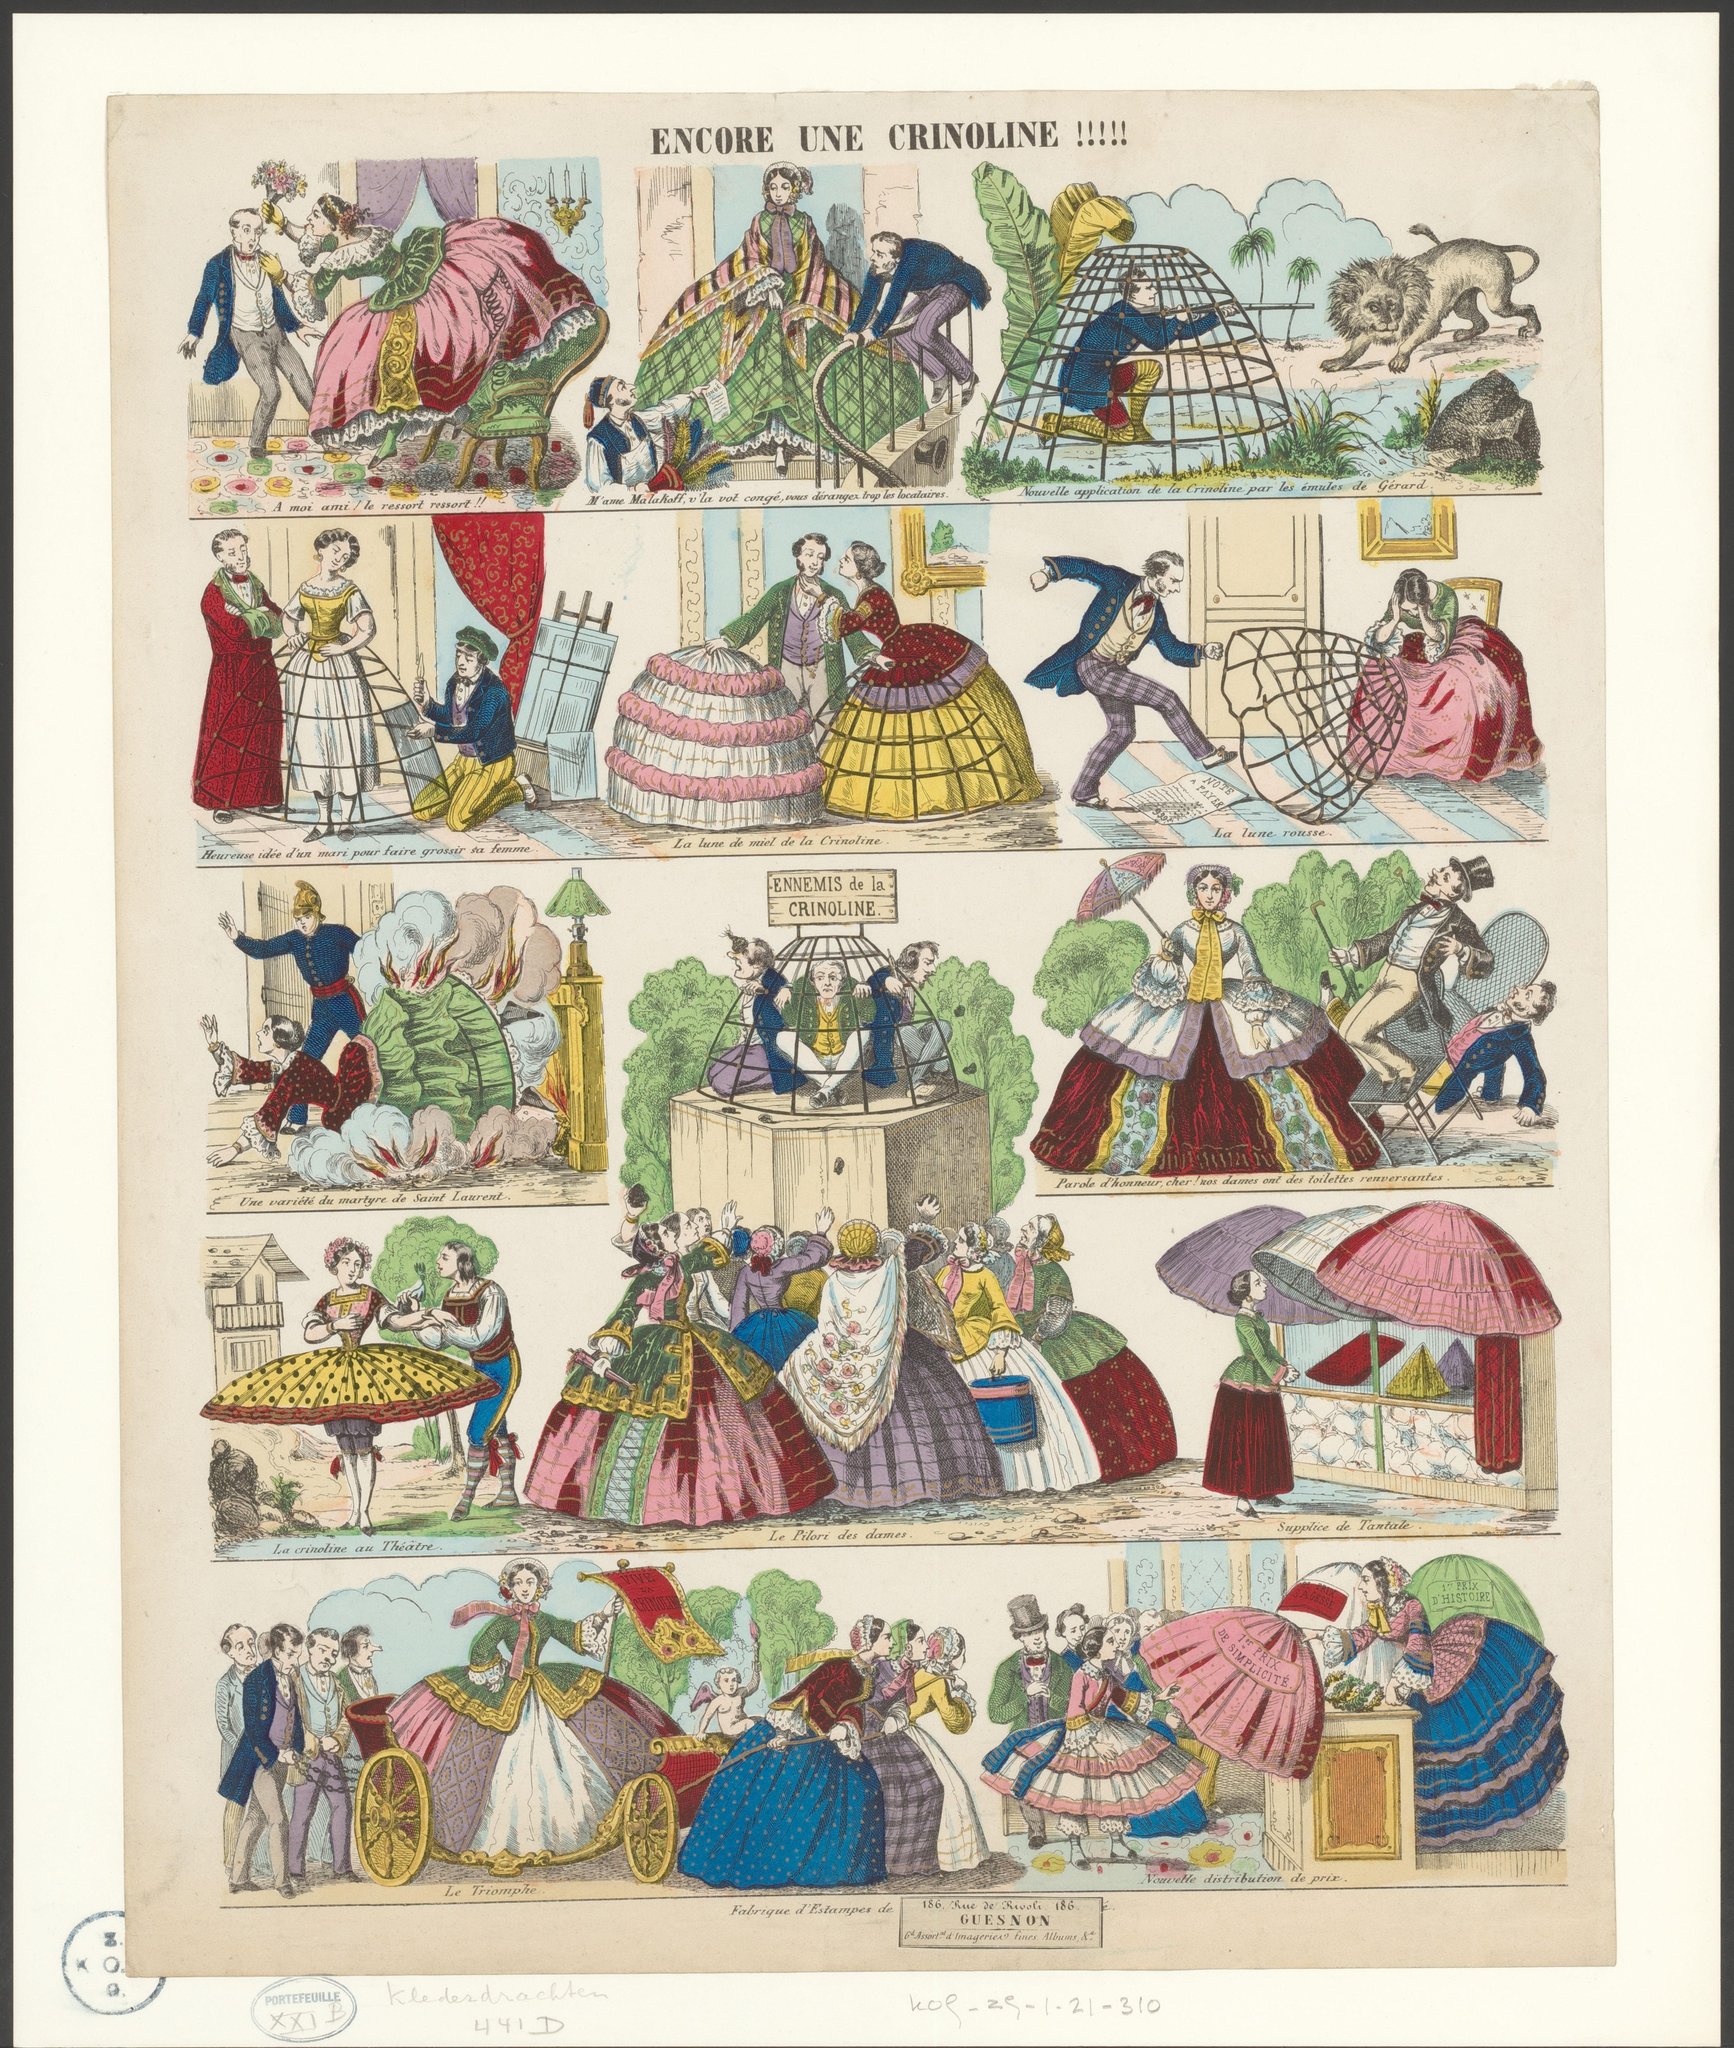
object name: print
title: Encore une crinoline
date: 1850-1870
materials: paint, paper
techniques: hand coloring, lithograph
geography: metz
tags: skirt (crinoline skirt) (+ women's clothes)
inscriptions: : ‘Déposé’, collector's mark: Lugt 1641, stamp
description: Volksprent met grappen over de hoepelrok of crinoline. De rokken van vrouwen hadden een wijde omtrek wat voor veel onhandigheden zorgden. Zo past heeft een vrouw te dicht bij het vuur gestaan en is haar rok vlam gevat. Een man gebruikt de hoepelrok ter bescherming bij de jacht. Vrouwen hebben drie mannen die tegen de hoepelrok zijn gevangen in de kooi van de rok. Drie rokken worden gebruikt als luifels voor een winkel. Onder elke afbeelding een regel tekst. Onderwerpsrubrieken binnen de Atlas Zeden en Gewoonten: Zeden en Gewoonten in Engeren Zin, De Kleeding, Kleederdrachten (tijdvakken), De crinolinetijd.